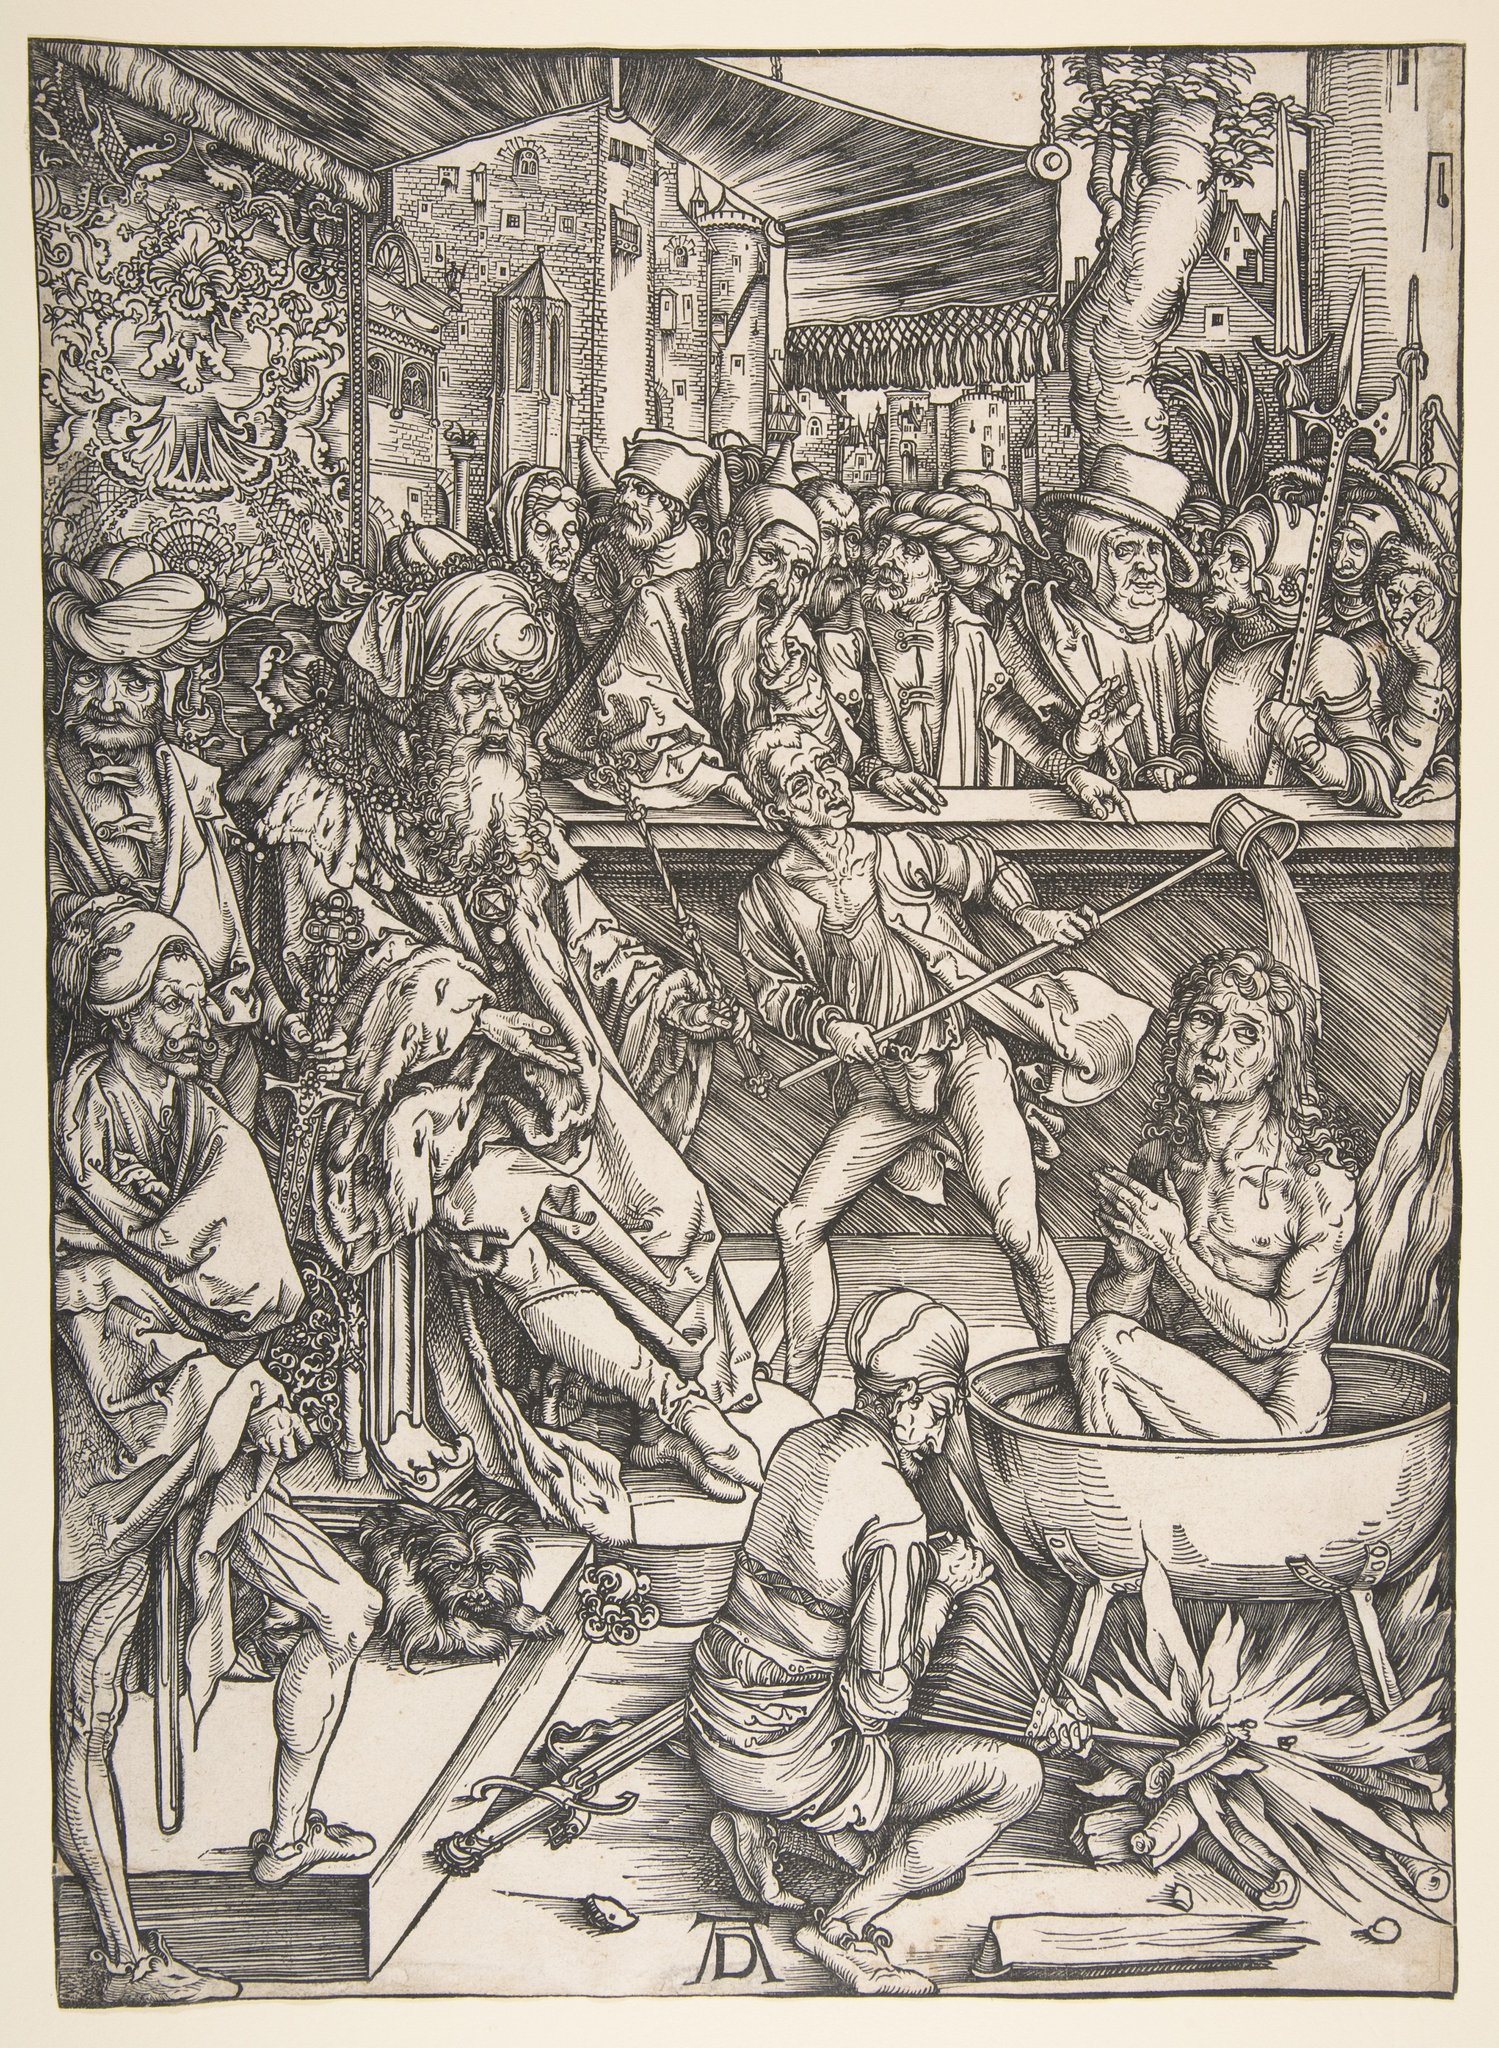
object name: print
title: The Martyrdom of Saint John, from "The Apocalypse"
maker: albrecht dürer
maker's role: artist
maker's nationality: german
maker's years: 1471-1528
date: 1511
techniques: woodcut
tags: men,women,dogs,saint john the baptist,apocalypse